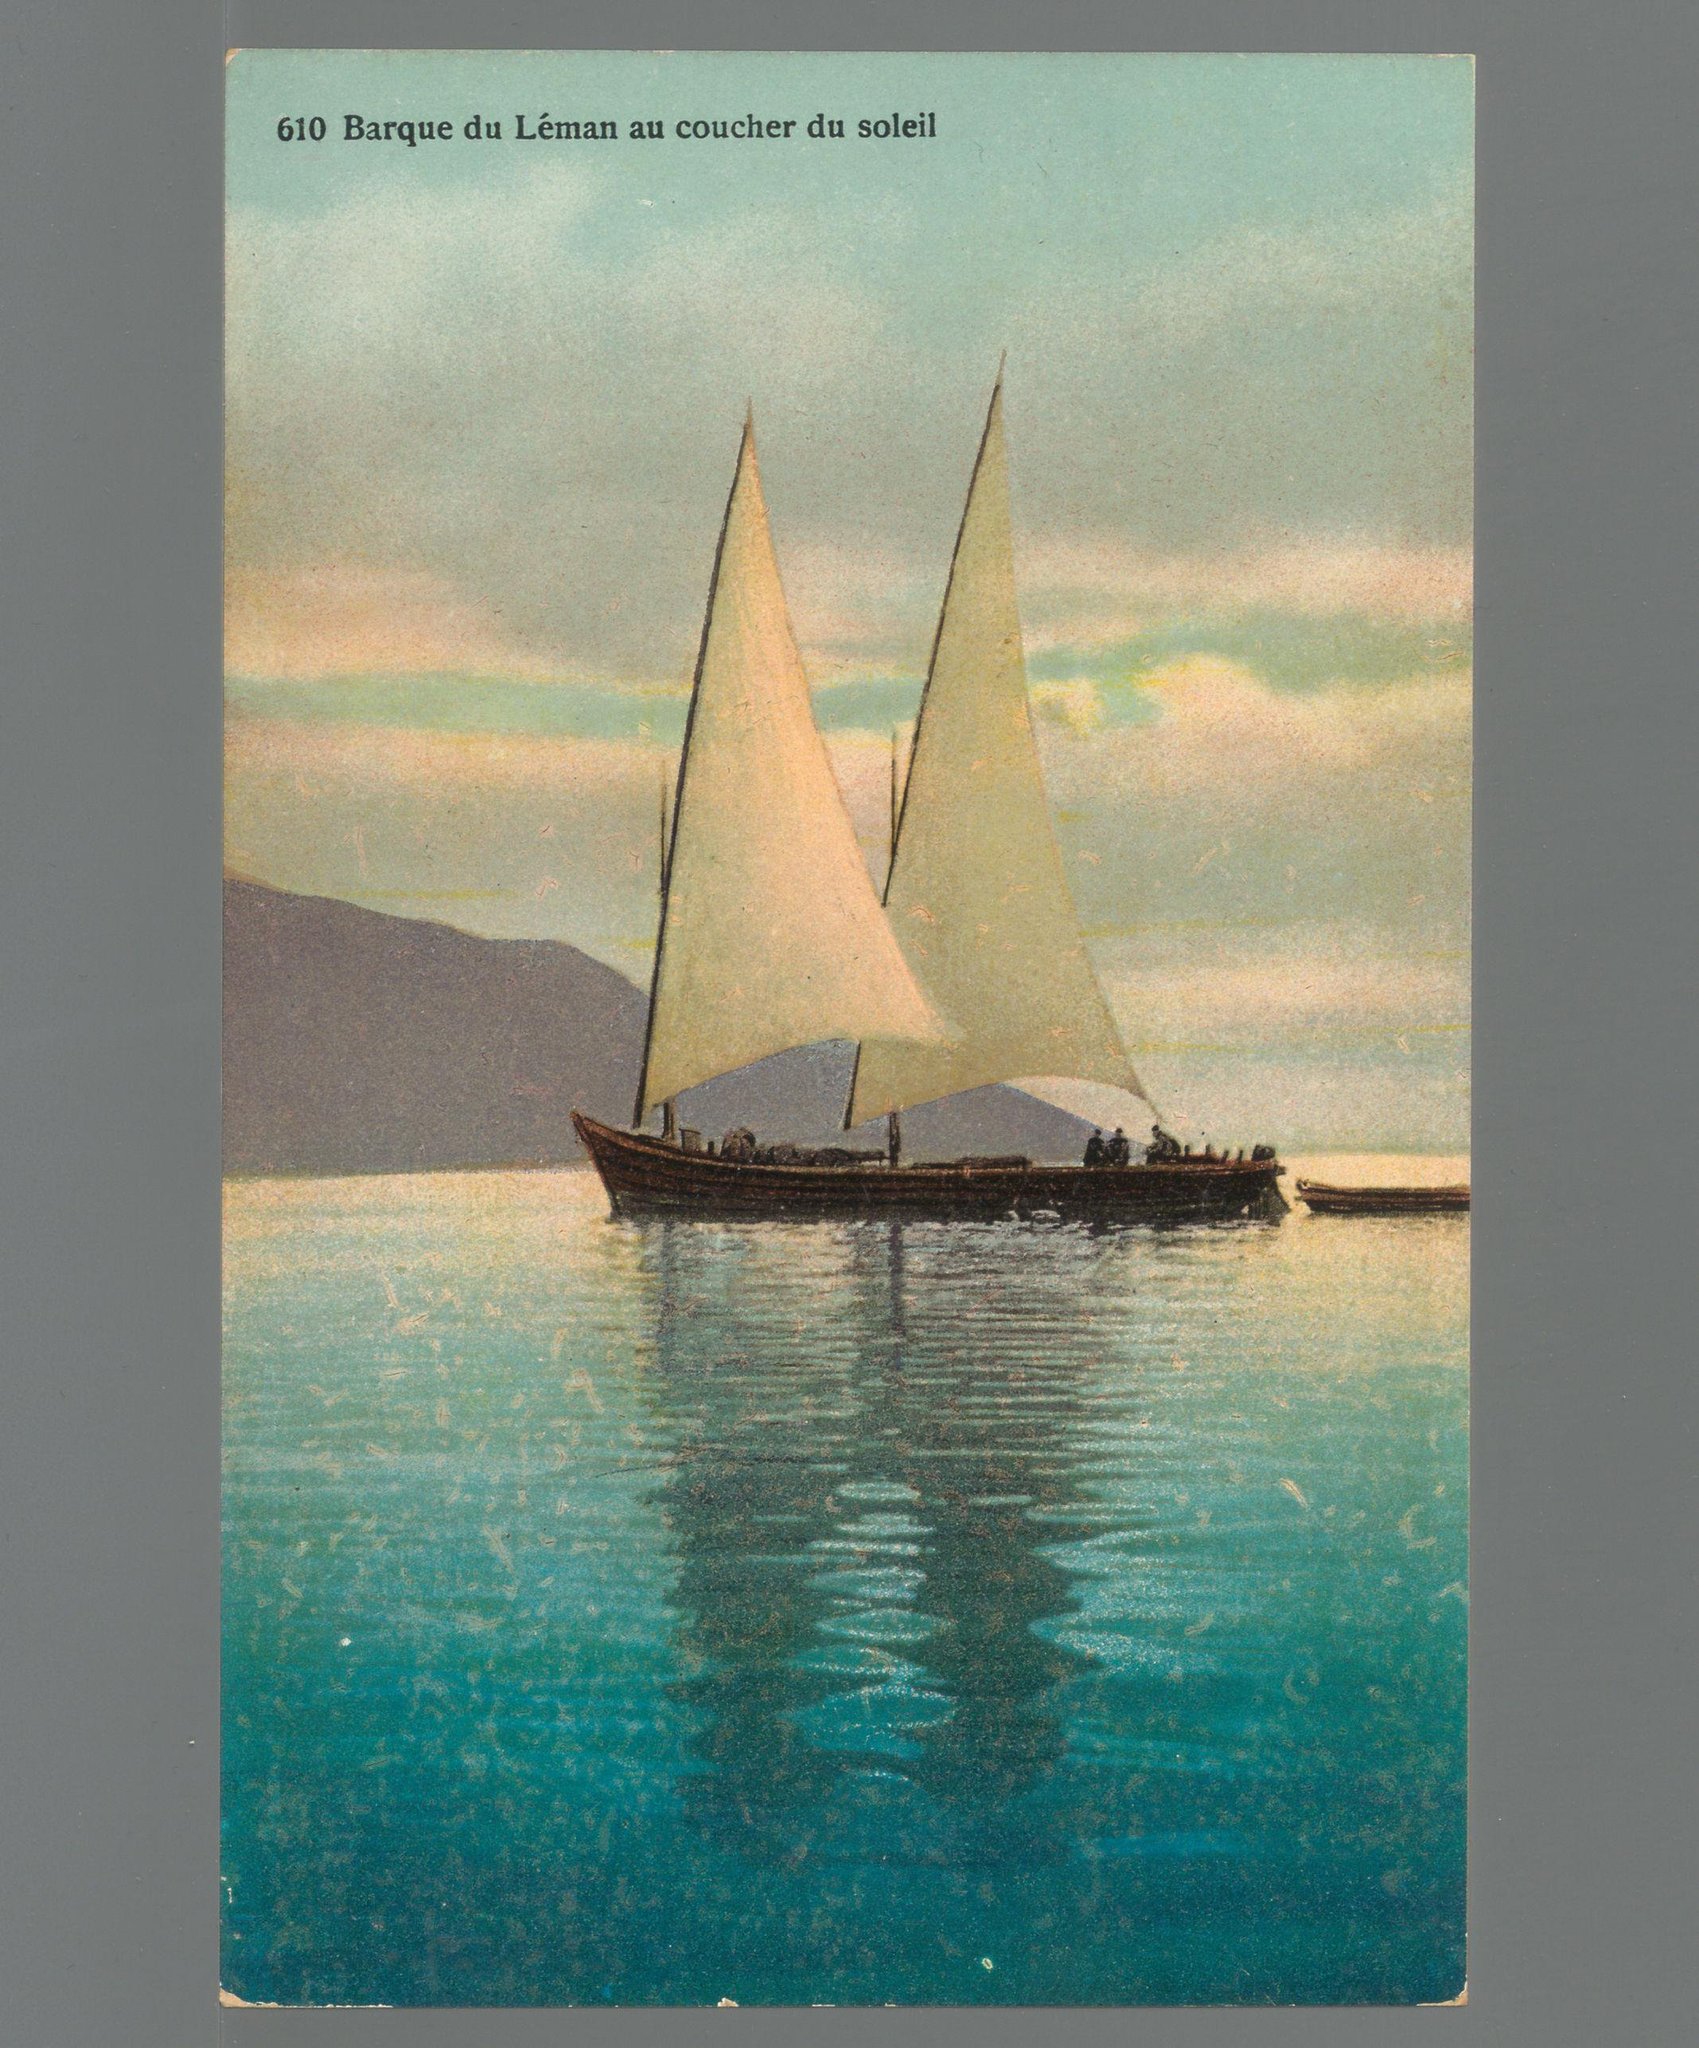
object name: photomechanical print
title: Barque du Léman au coucher du soleil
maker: Anonymous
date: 1905-1909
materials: cardboard, photographic process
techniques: writing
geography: geneva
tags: lake, lake (+ landscape with figures, staffage)